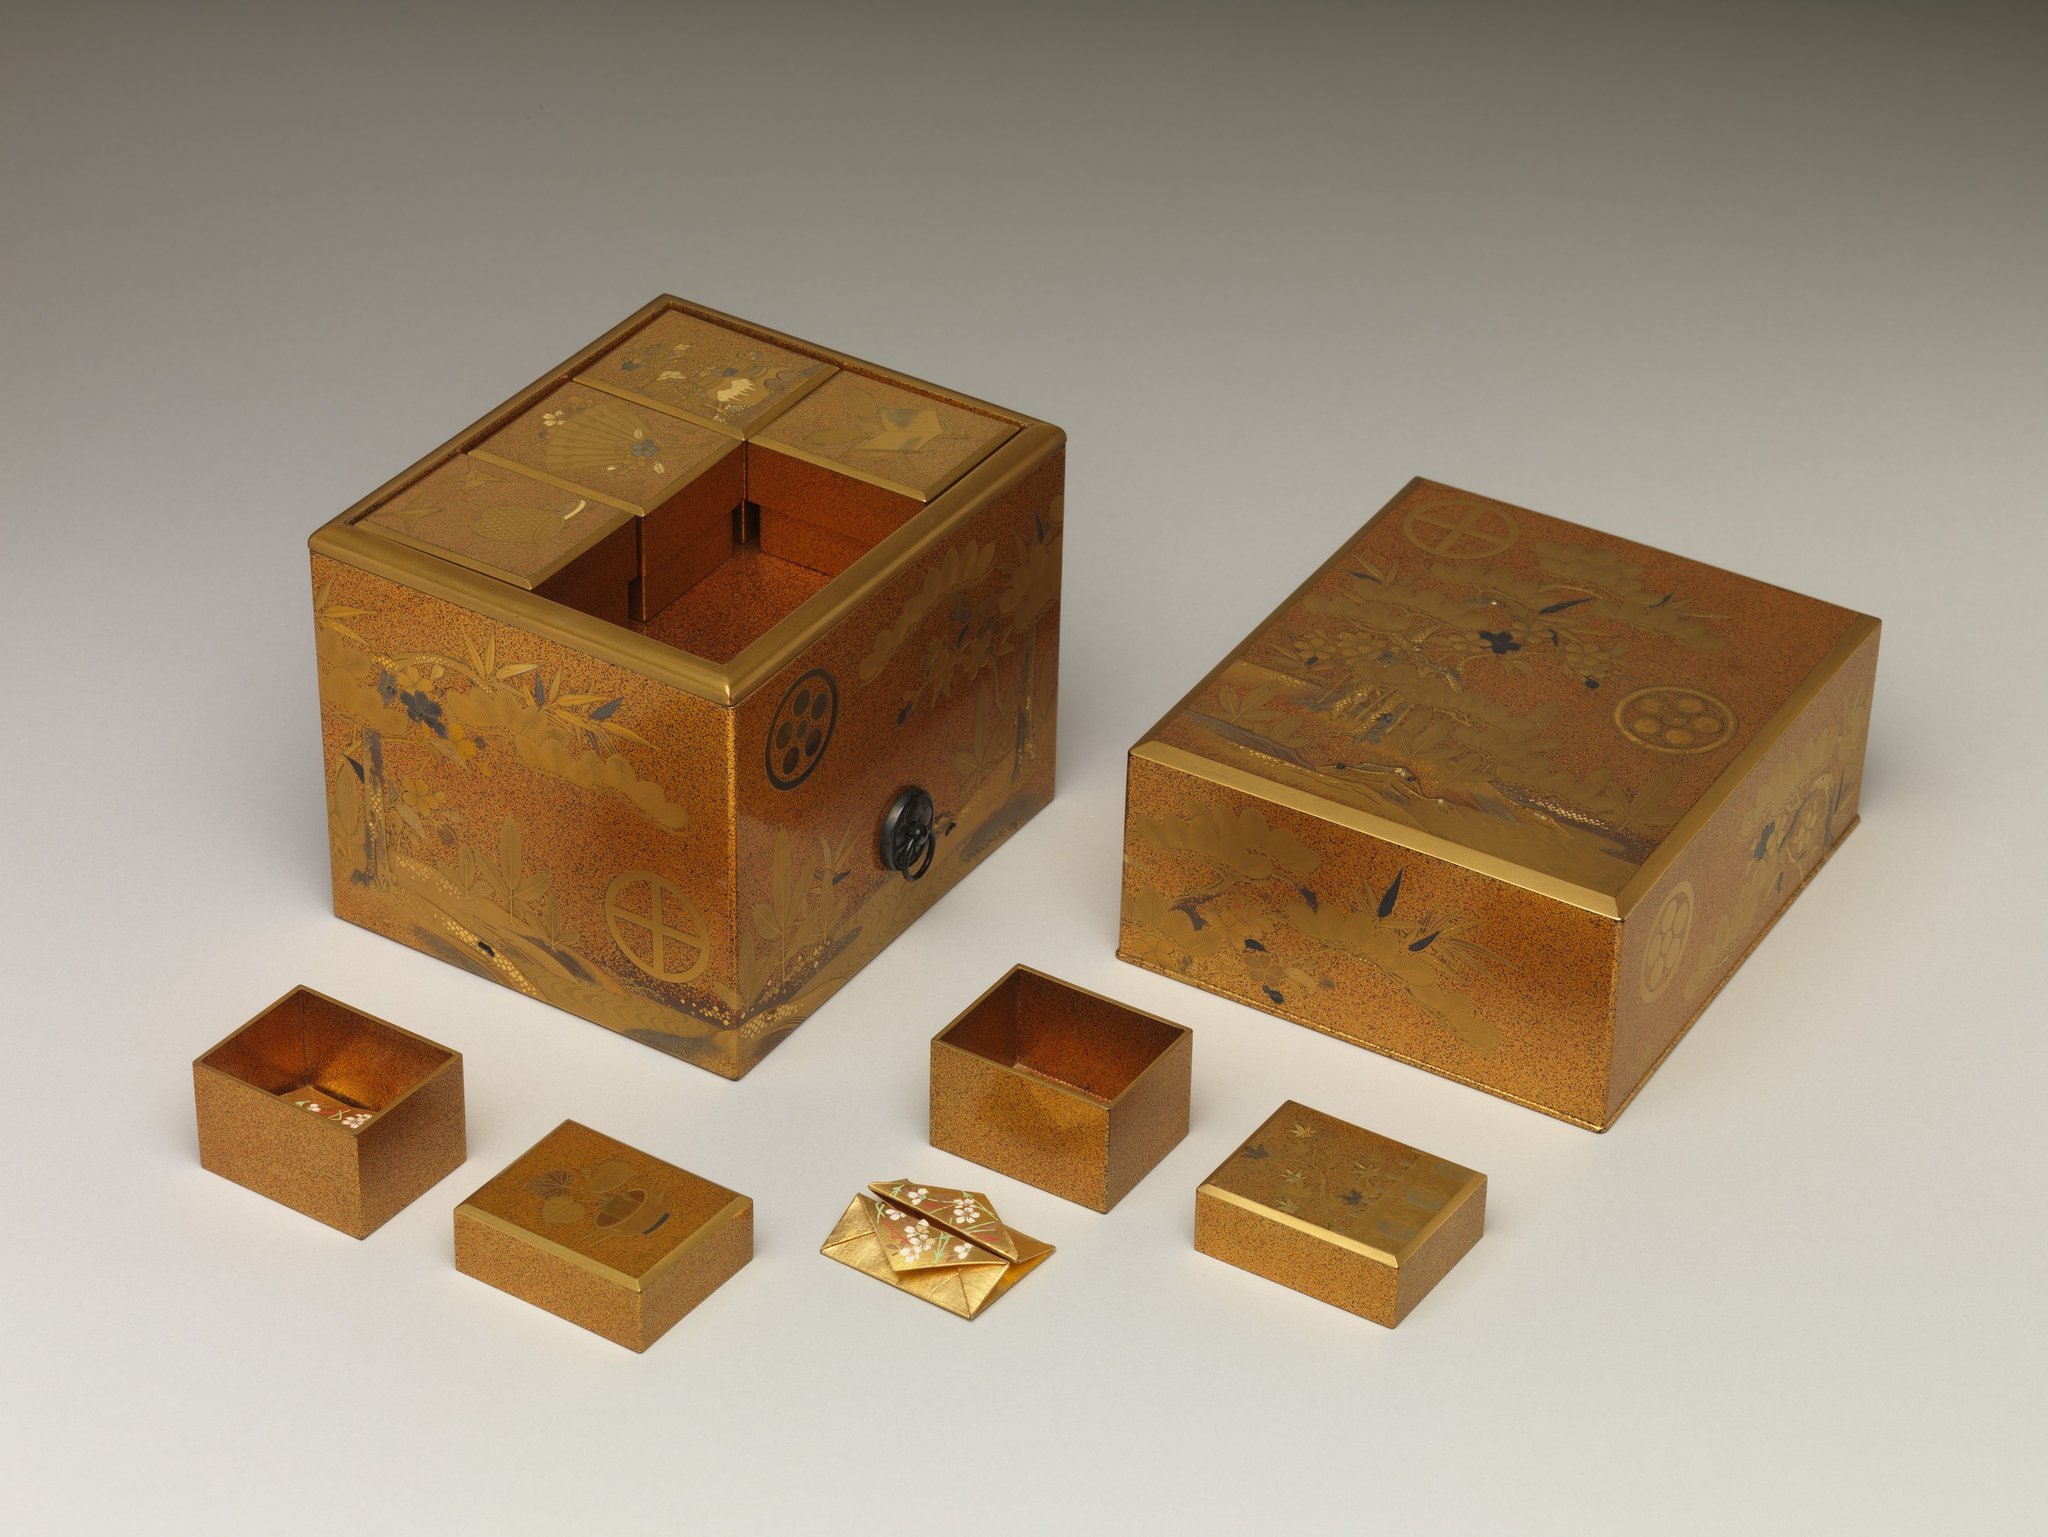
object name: box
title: Box with Design of Pine, Bamboo, and Cherry Blossom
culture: japanese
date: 1801-1900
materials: gold, lacquer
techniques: maki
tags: flowers,trees